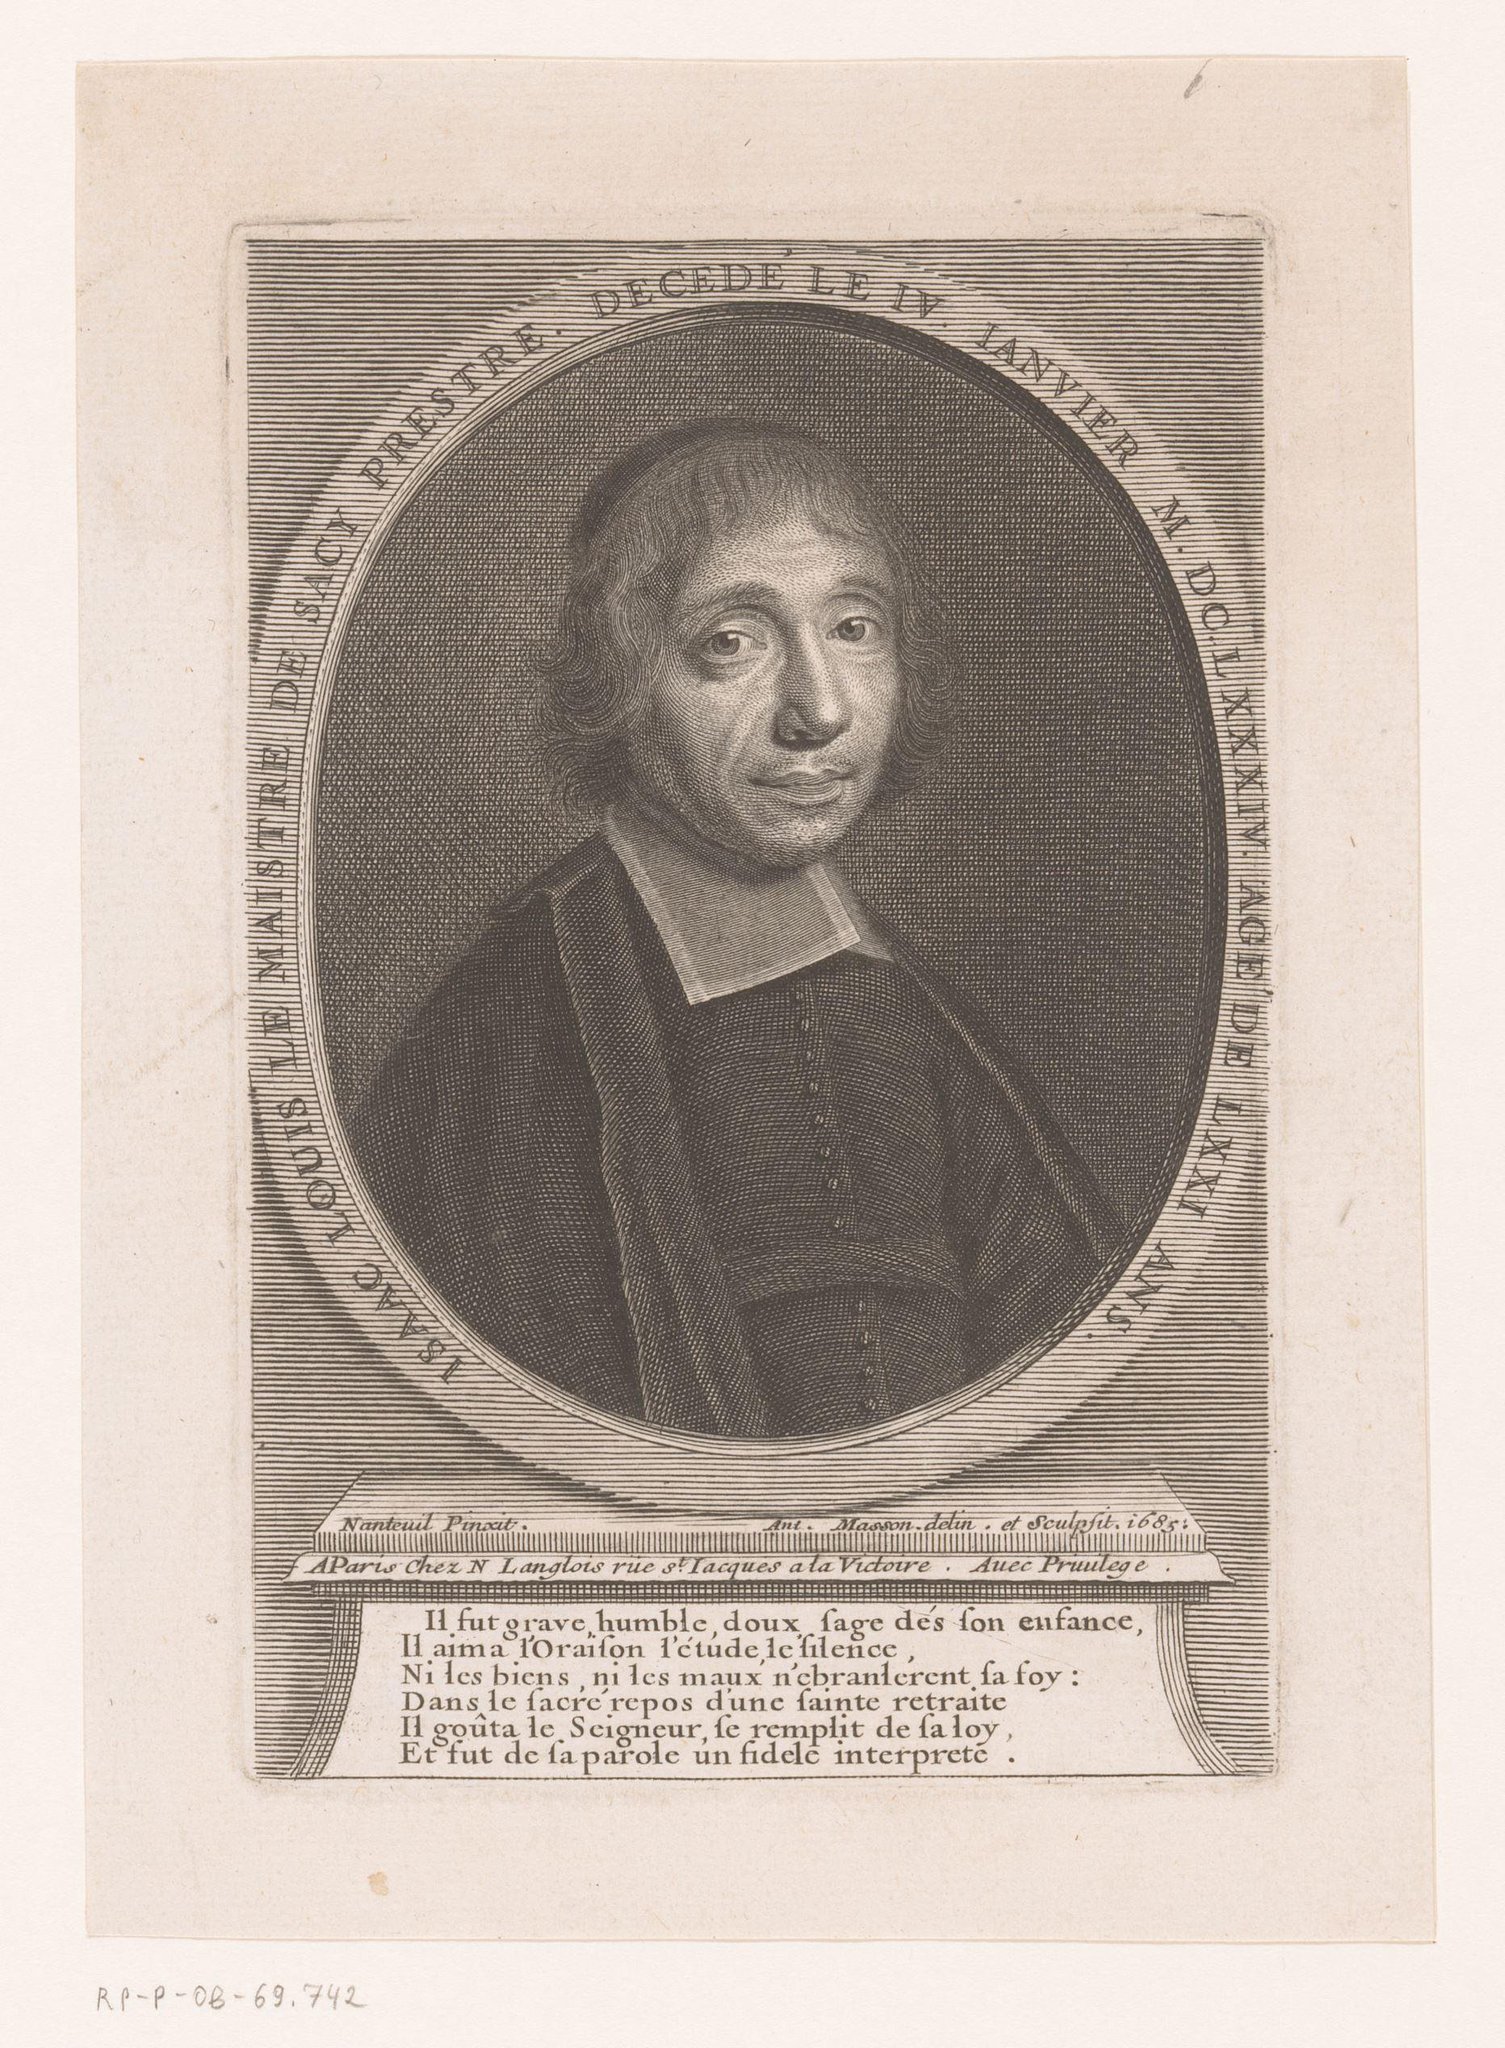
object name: print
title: Portret van Louis-Isaac Lemaistre de Sacy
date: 1685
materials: paper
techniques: engraving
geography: france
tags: paris, priest, historical persons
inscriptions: collector's mark: Lugt 2228